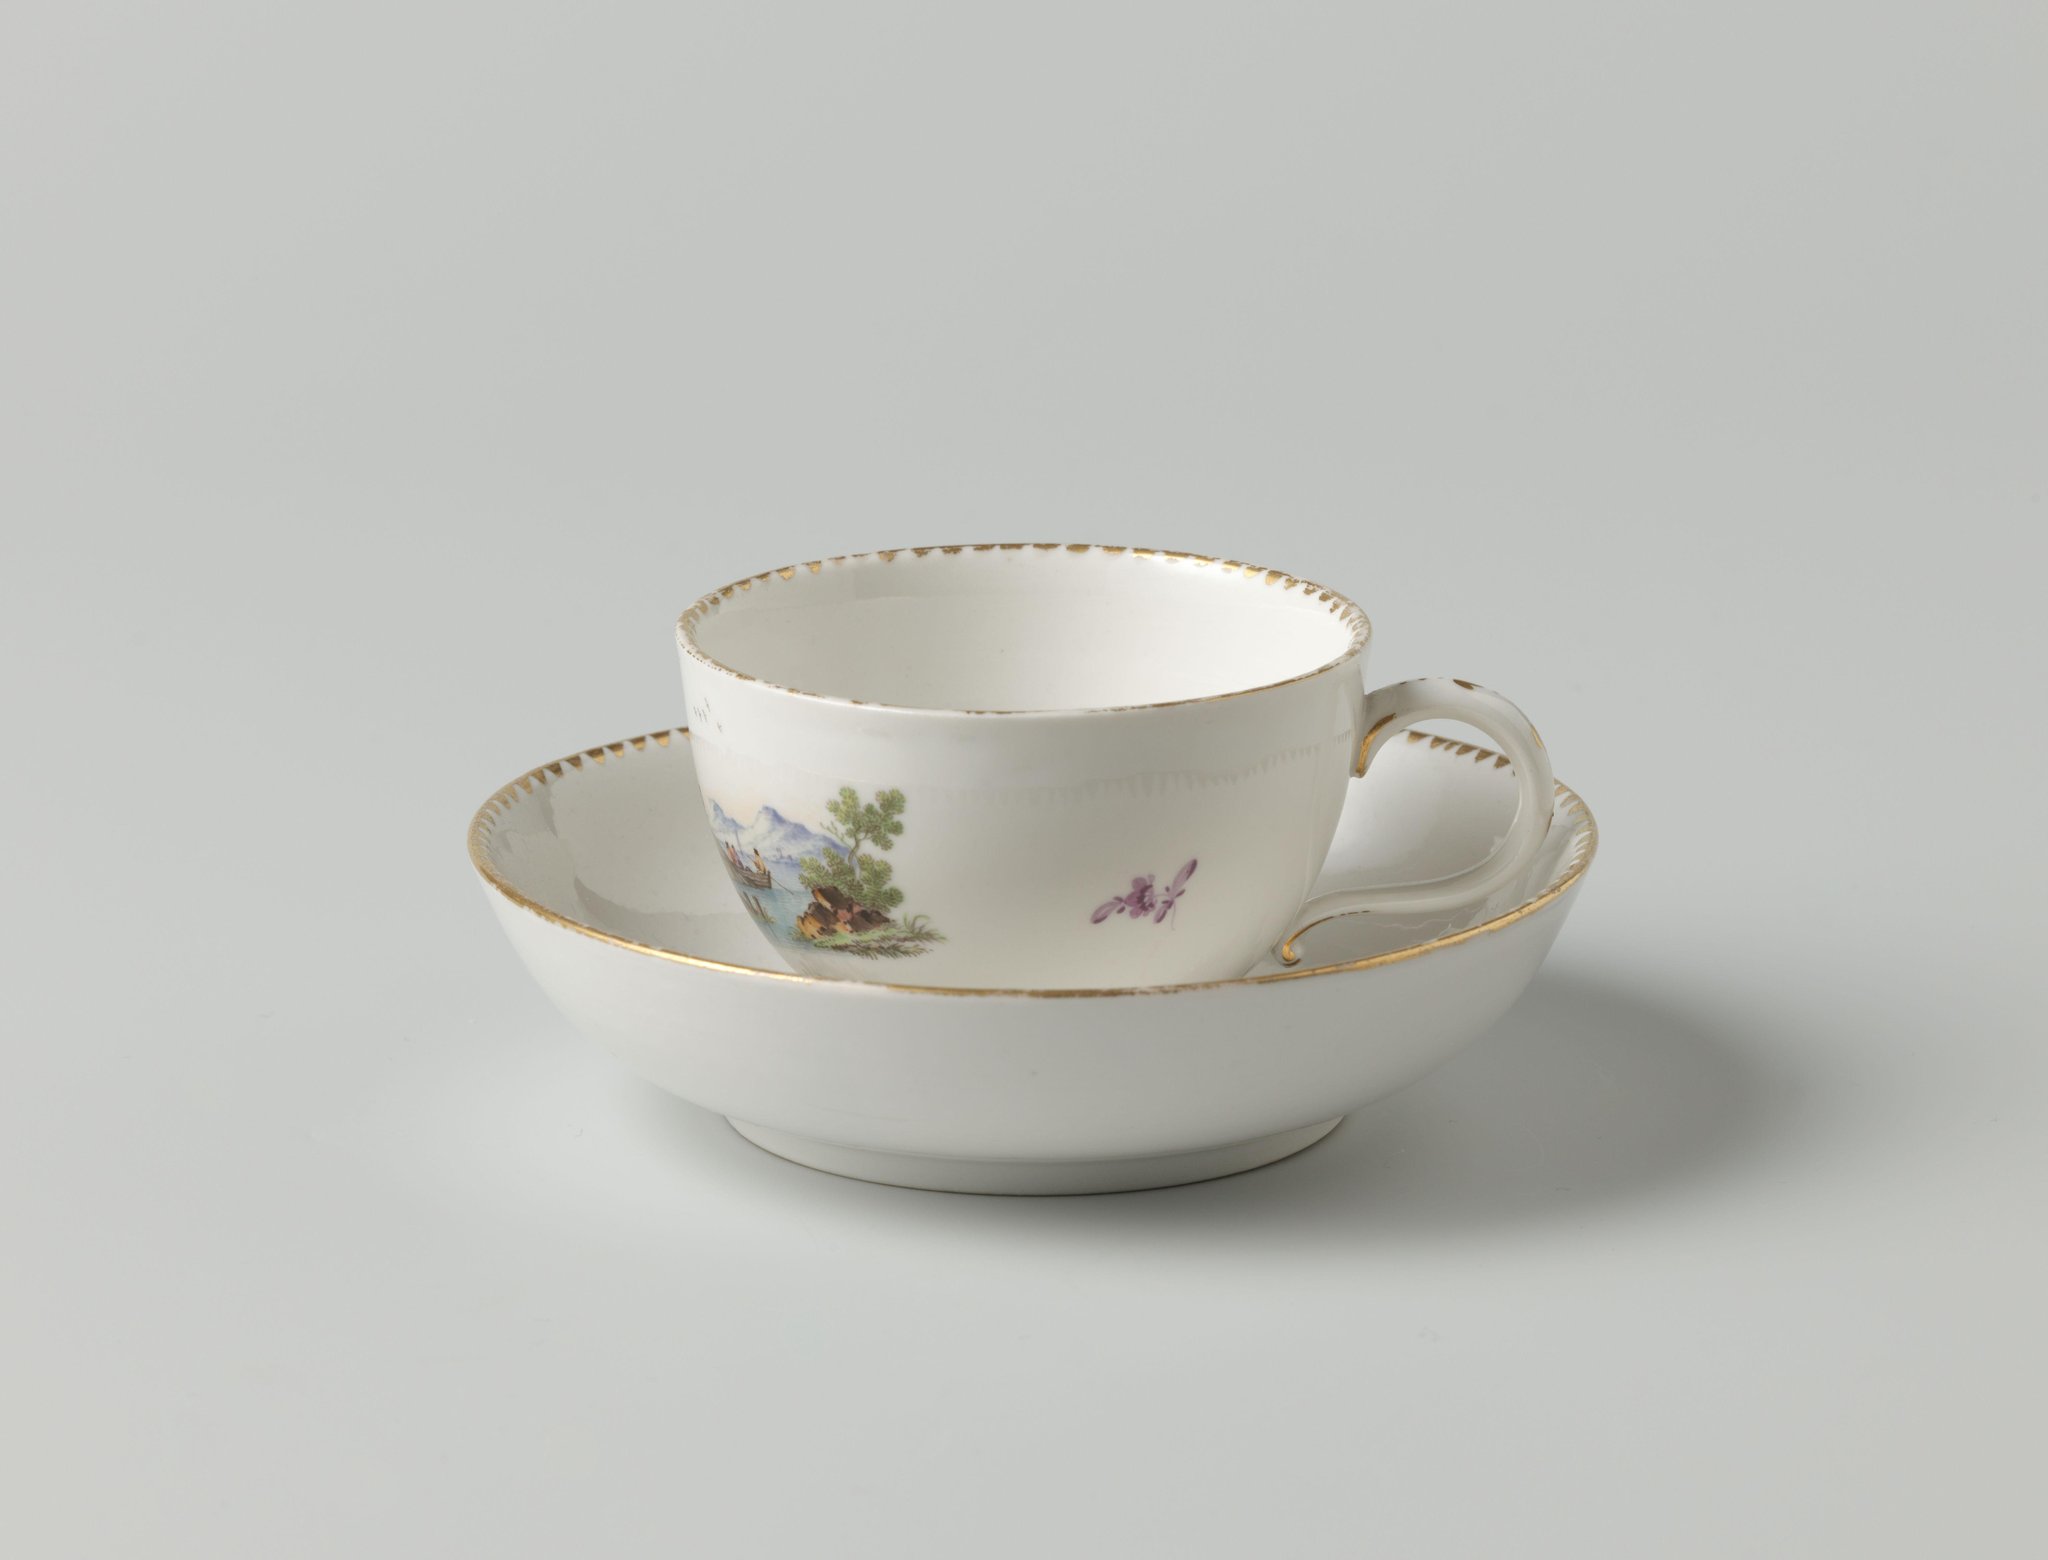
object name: platter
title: Schotel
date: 1777-1790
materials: porcelain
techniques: painted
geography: the hague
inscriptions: mark: ‘blauwe ooievaar’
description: Schotel veelkleurig beschilderd met figuren in een waterlandschap. Gouden biezen langs de randen.